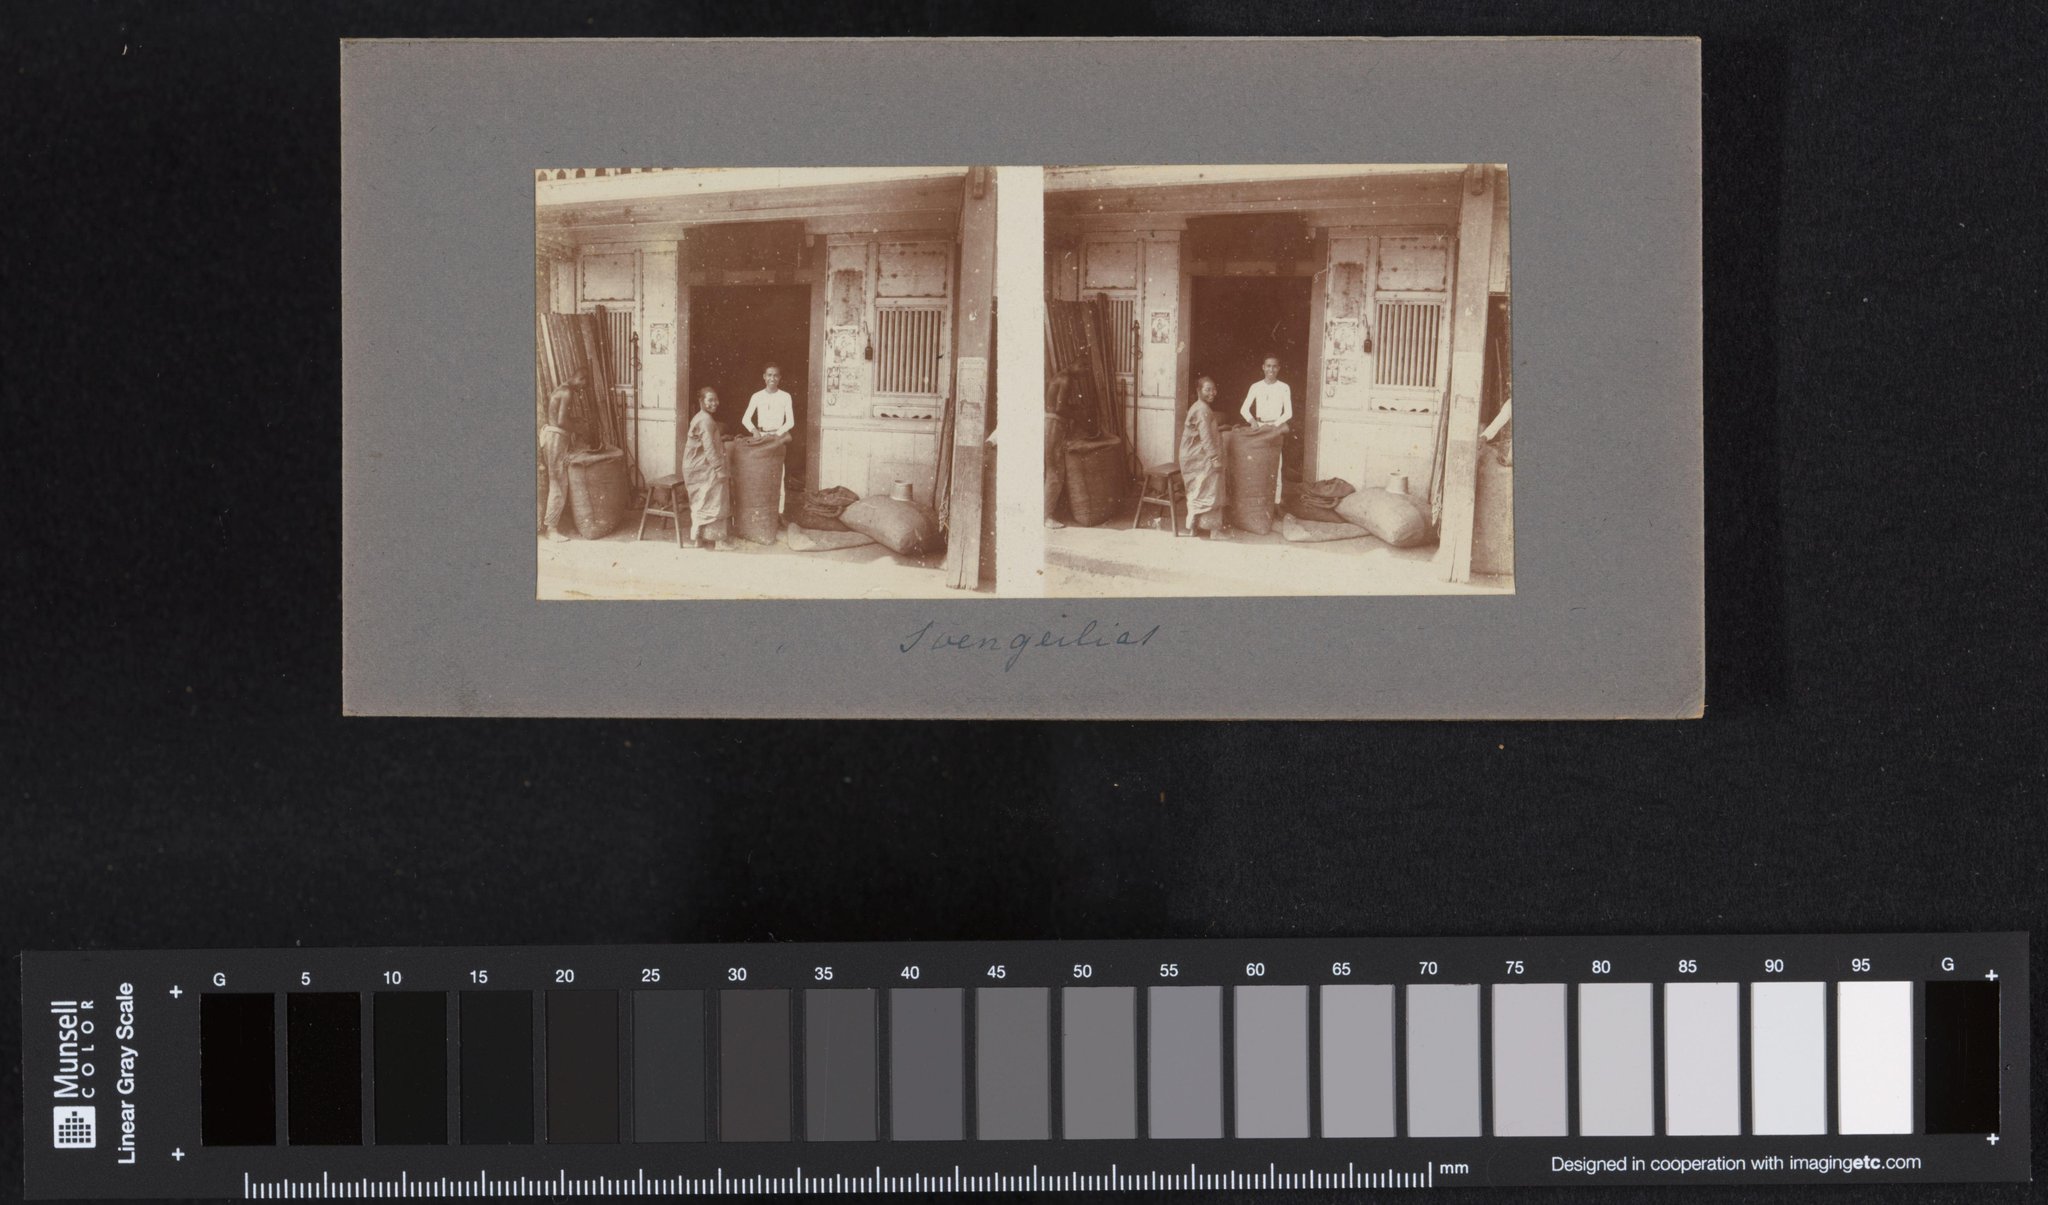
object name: stereograph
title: Man en vrouw voor winkel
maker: robert julius boers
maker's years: 1867-1932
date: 1900-1922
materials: cardboard, photographic support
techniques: gelatin silver print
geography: bangka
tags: robert julius boers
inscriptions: inscription: ‘Soengeiliat’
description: Indische man en vrouw bij het dichtbinden van een grote zak voor een winkel of magazijn te Soengeiliat op Banka. Onderdeel van een groep stereofoto's van Robert Julius Boers, chef van het staatsbedrijf de Banka-tinwinning op Banka, uit de periode ca. 1900-1922.